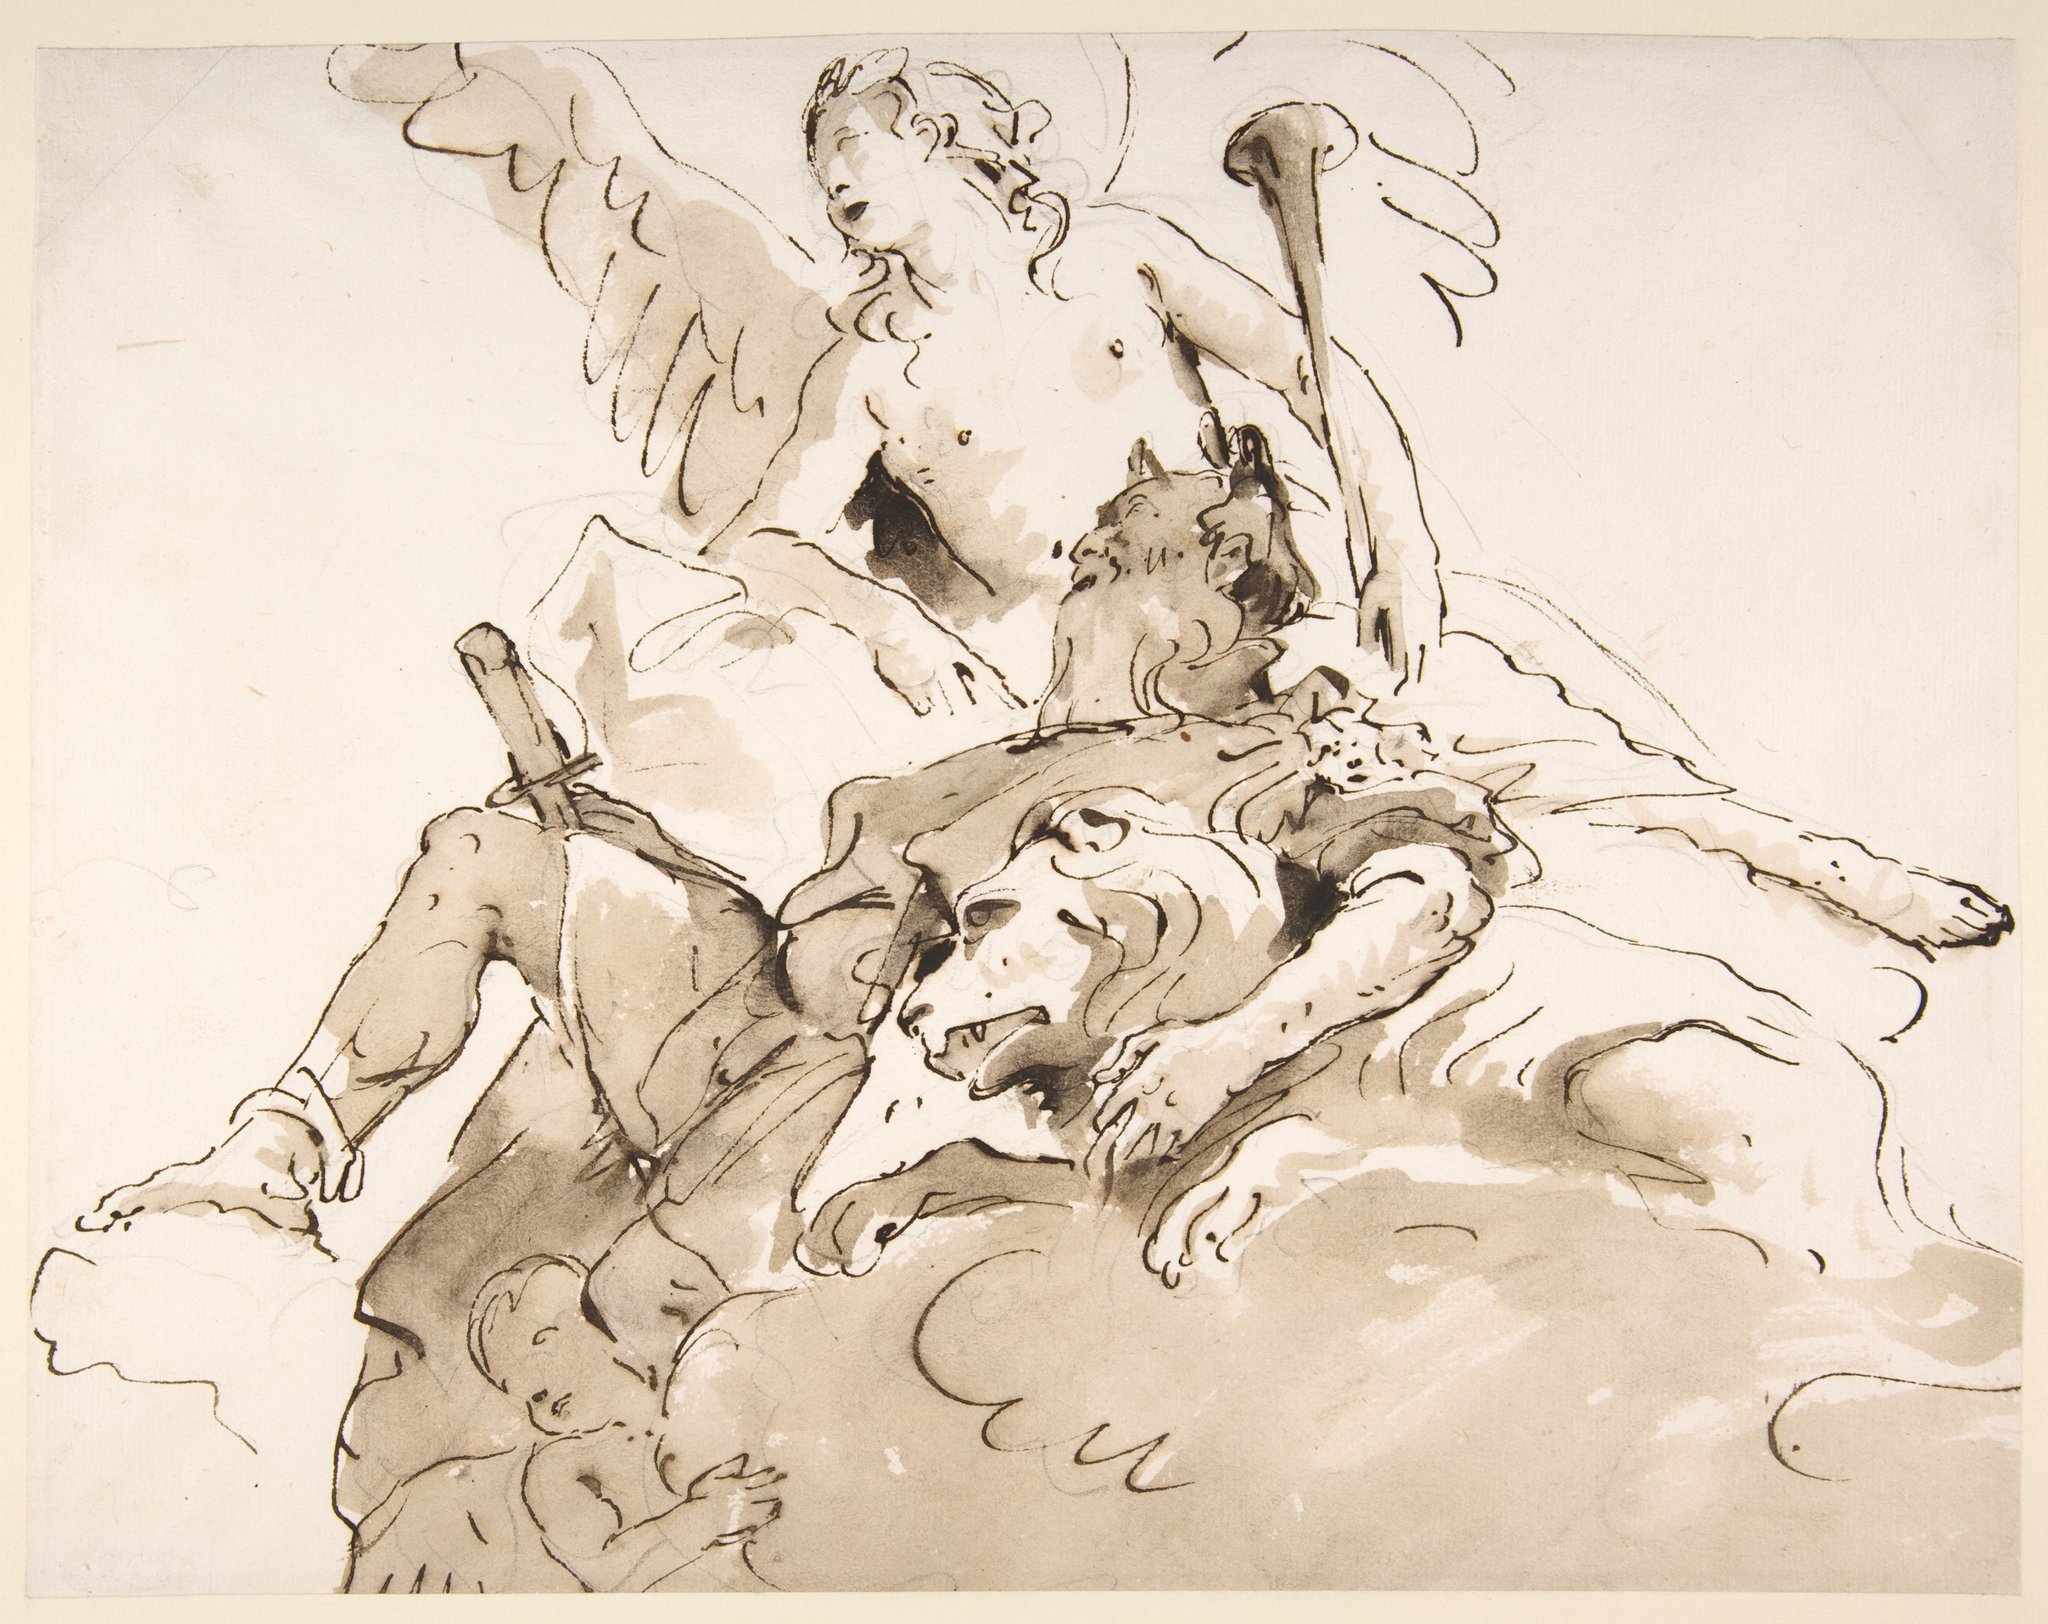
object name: drawing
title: Apotheosis of a Warrior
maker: giovanni battista tiepolo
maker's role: artist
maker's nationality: italian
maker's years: 1696-1770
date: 1696-1770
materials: chalk, ink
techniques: brush, pen, wash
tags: animals,soldiers